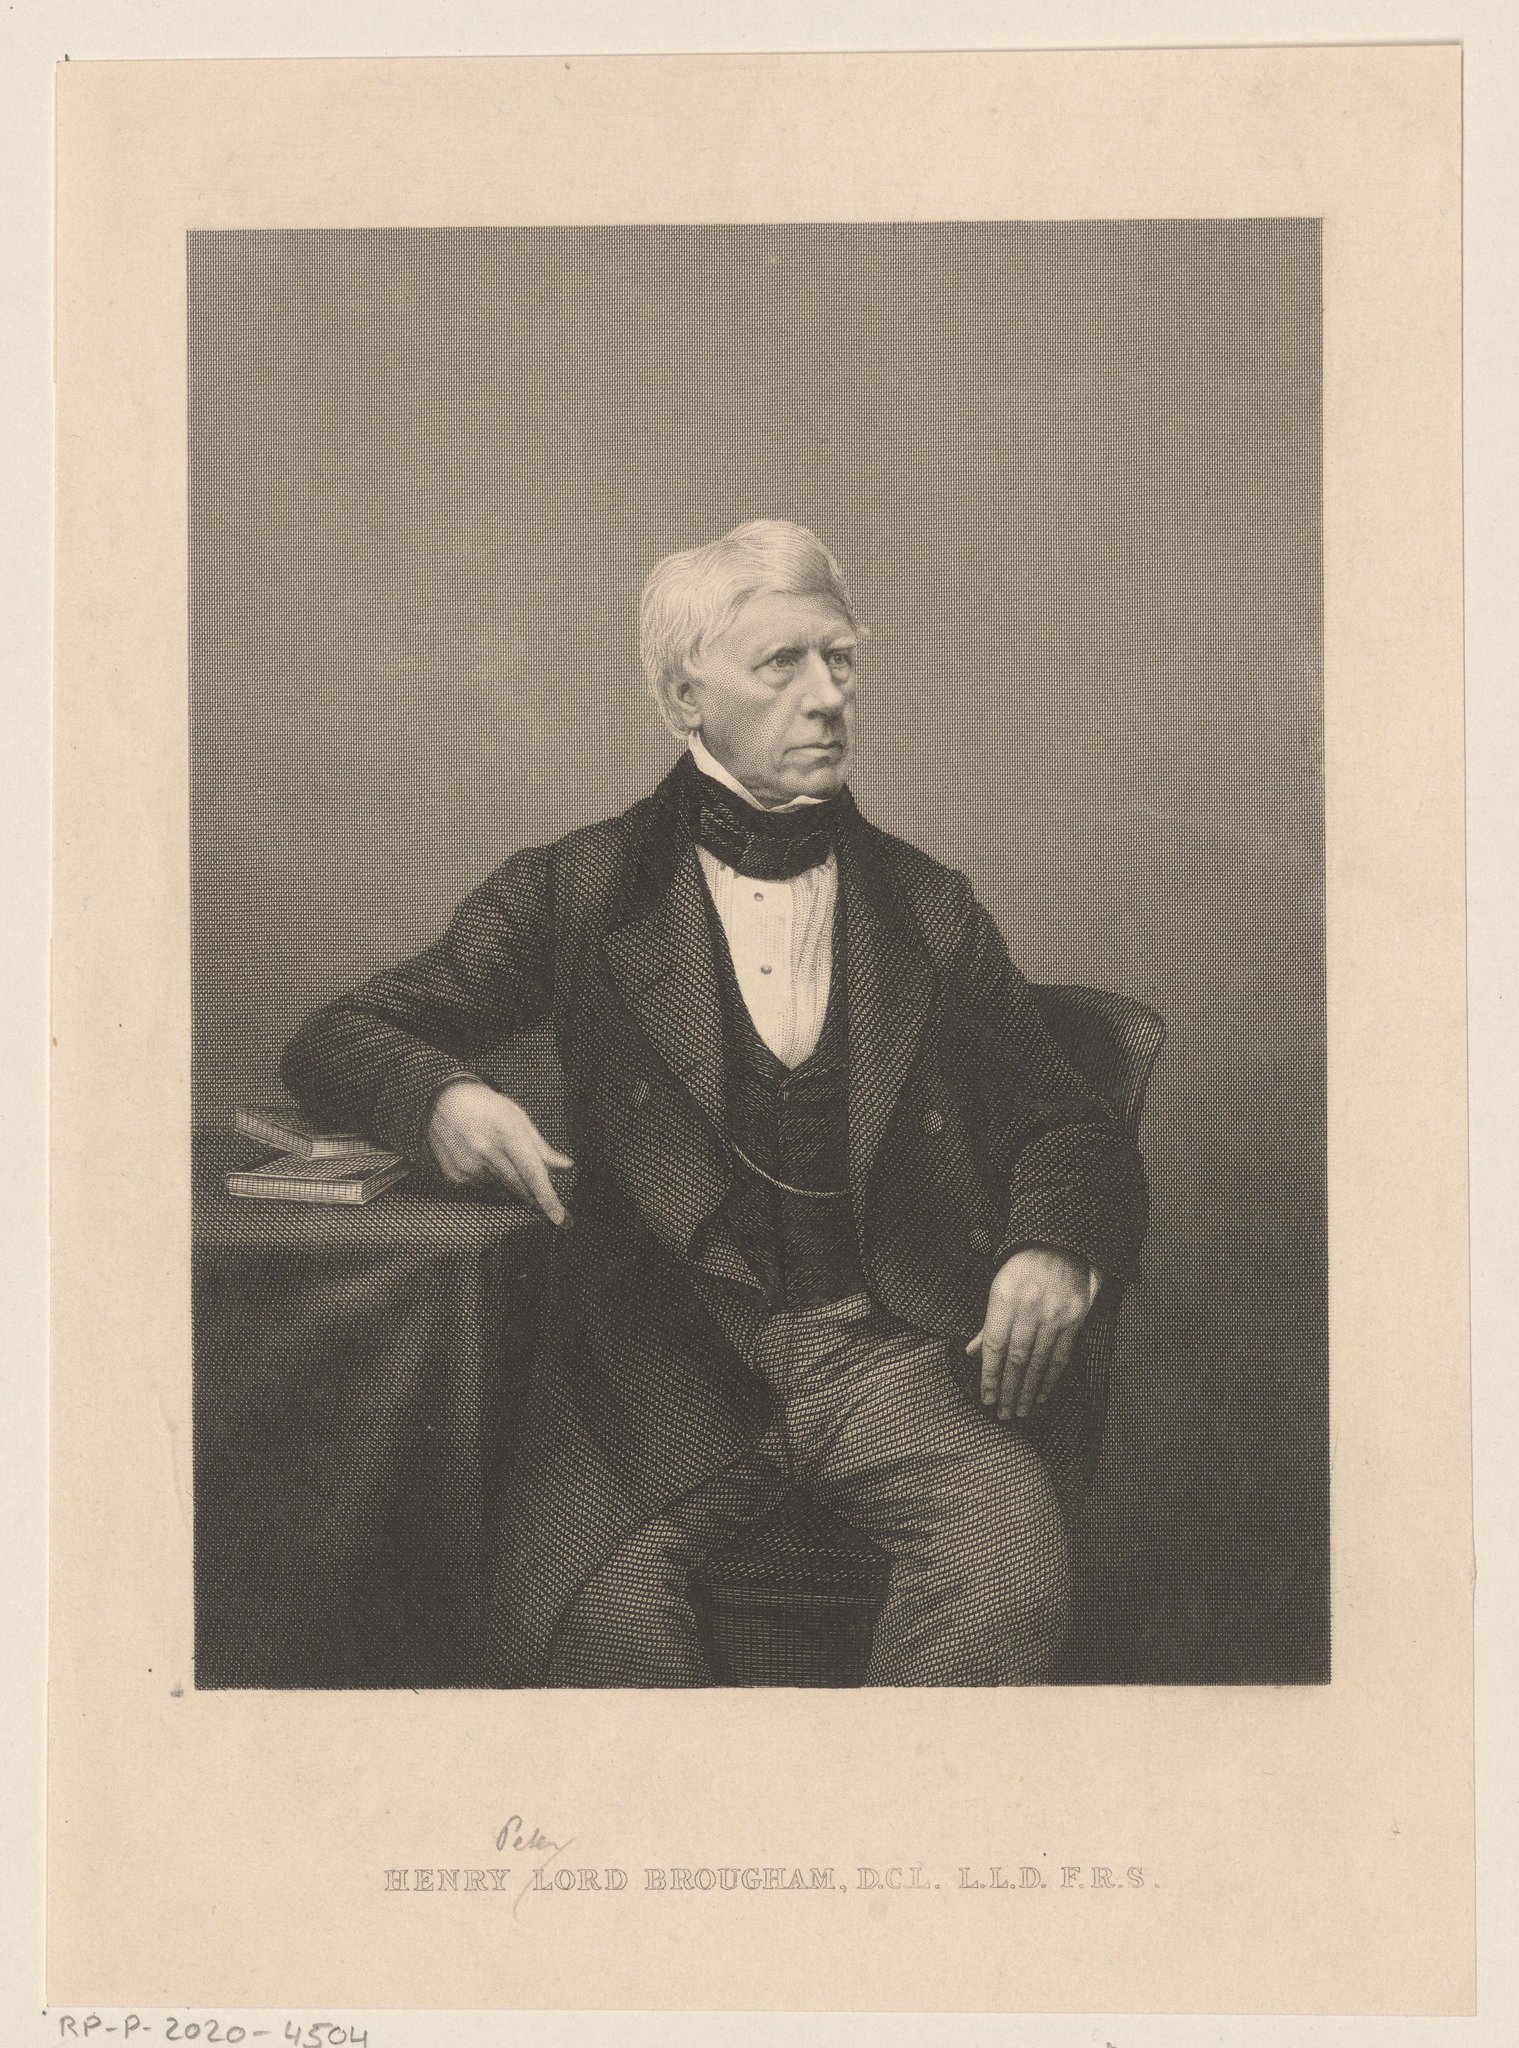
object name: print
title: Portret van Henry Peter Brougham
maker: Anonymous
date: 1850-1899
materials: paper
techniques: engraving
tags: official; civil servant; functionary (in general), historical persons